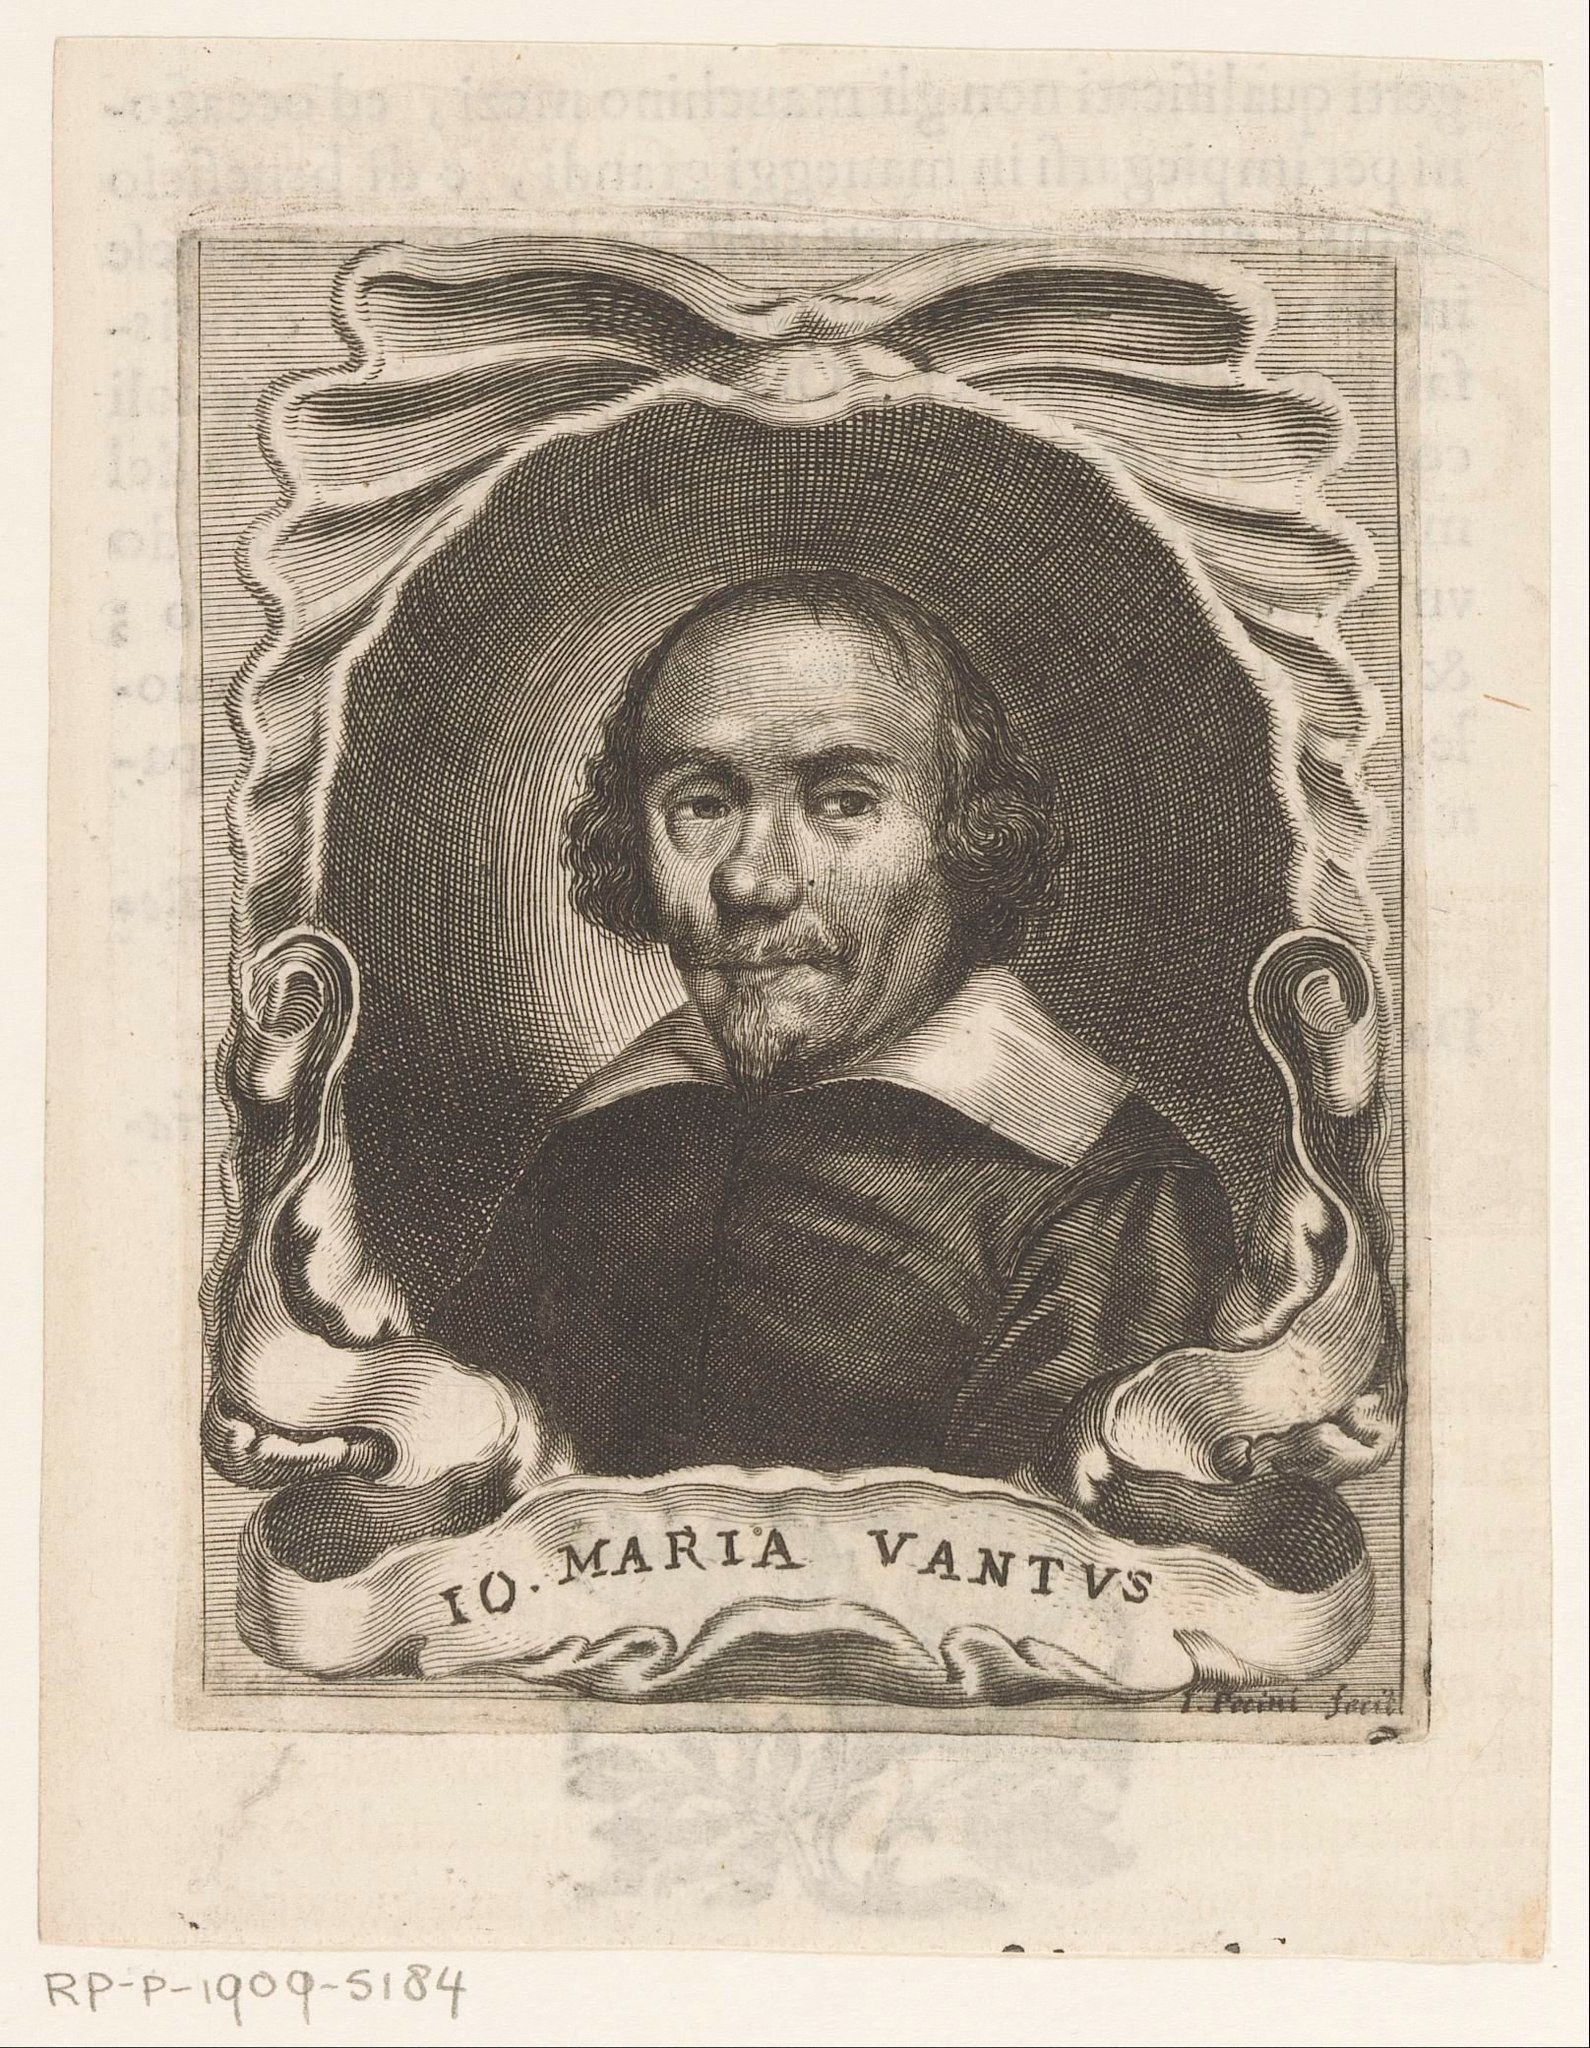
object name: book illustration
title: Portret van geestelijke Giovanni Maria Vanti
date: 1647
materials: paper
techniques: engraving, letterpress printing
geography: venice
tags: clergyman, historical persons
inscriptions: collector's mark: Lugt 2228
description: Prent uit de publicatie: Loredan, Giovan Francesco. Le glorie degli Incogniti. Venetië: Francesco Valvasense, 1647, p. 252.